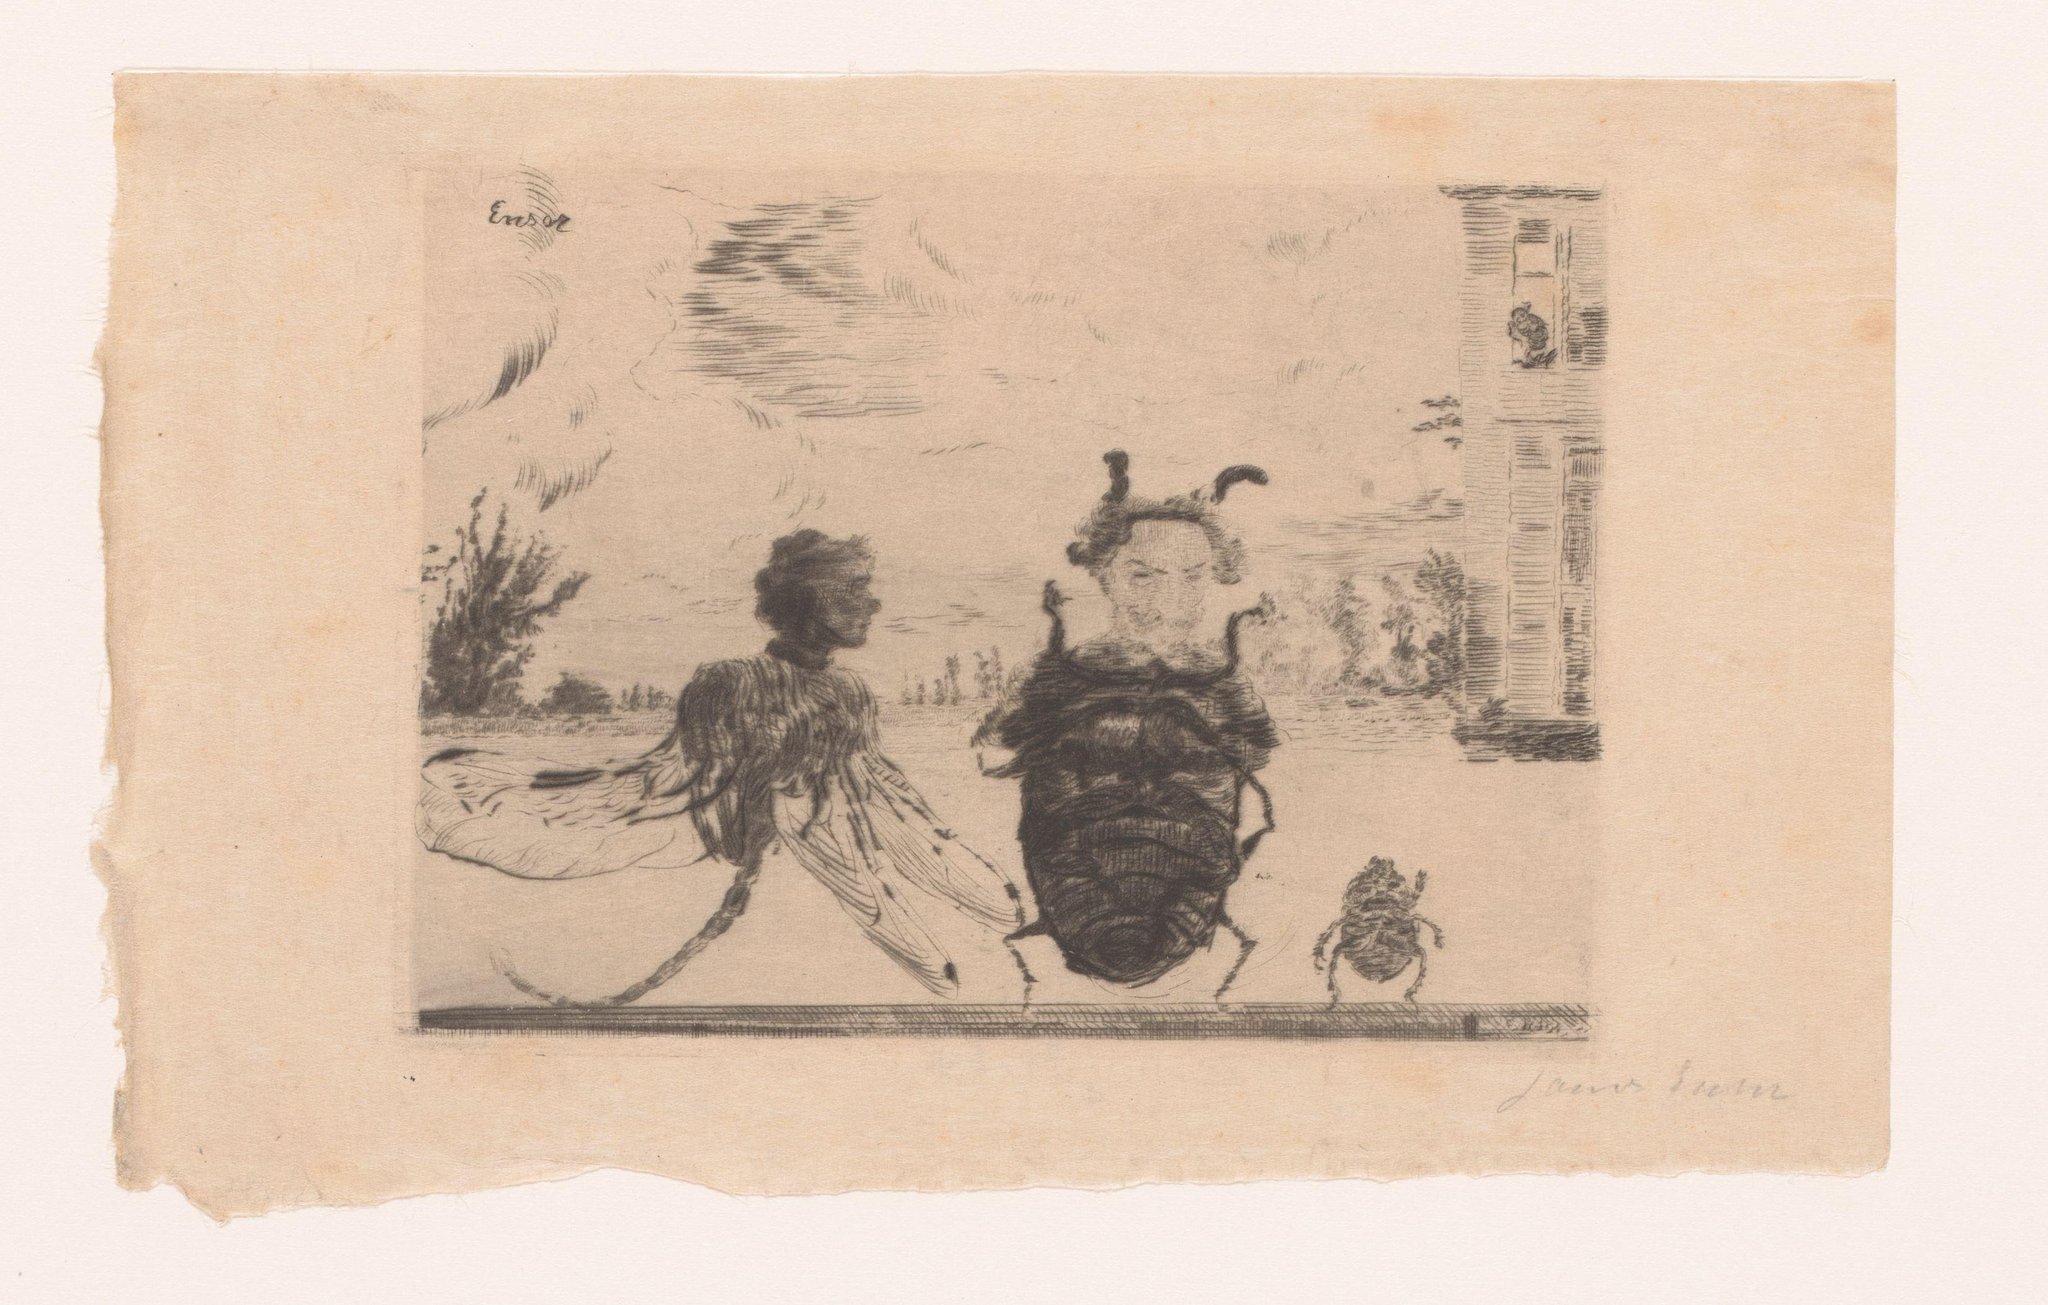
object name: print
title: Insectes singuliers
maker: james ensor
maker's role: print maker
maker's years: 1860-1949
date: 1888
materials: paper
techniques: drypoint, etching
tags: print maker, james ensor, insects, animals with human head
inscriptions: collector's mark: Lugt 2228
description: De kever heeft het hoofd van James Ensor en de waterjuffer is waarschijnlijk Mariëtte Rousseau-Hannon. Haar huis was een ontmoetingsplaats voor kunstenaars en geleerden. James kende Mariëtte goed. De voorstelling is mogelijk een vriendenportret ingegeven door een gedicht van Heinrich Heine over de onmogelijke liefde tussen een kever en een vlieg.